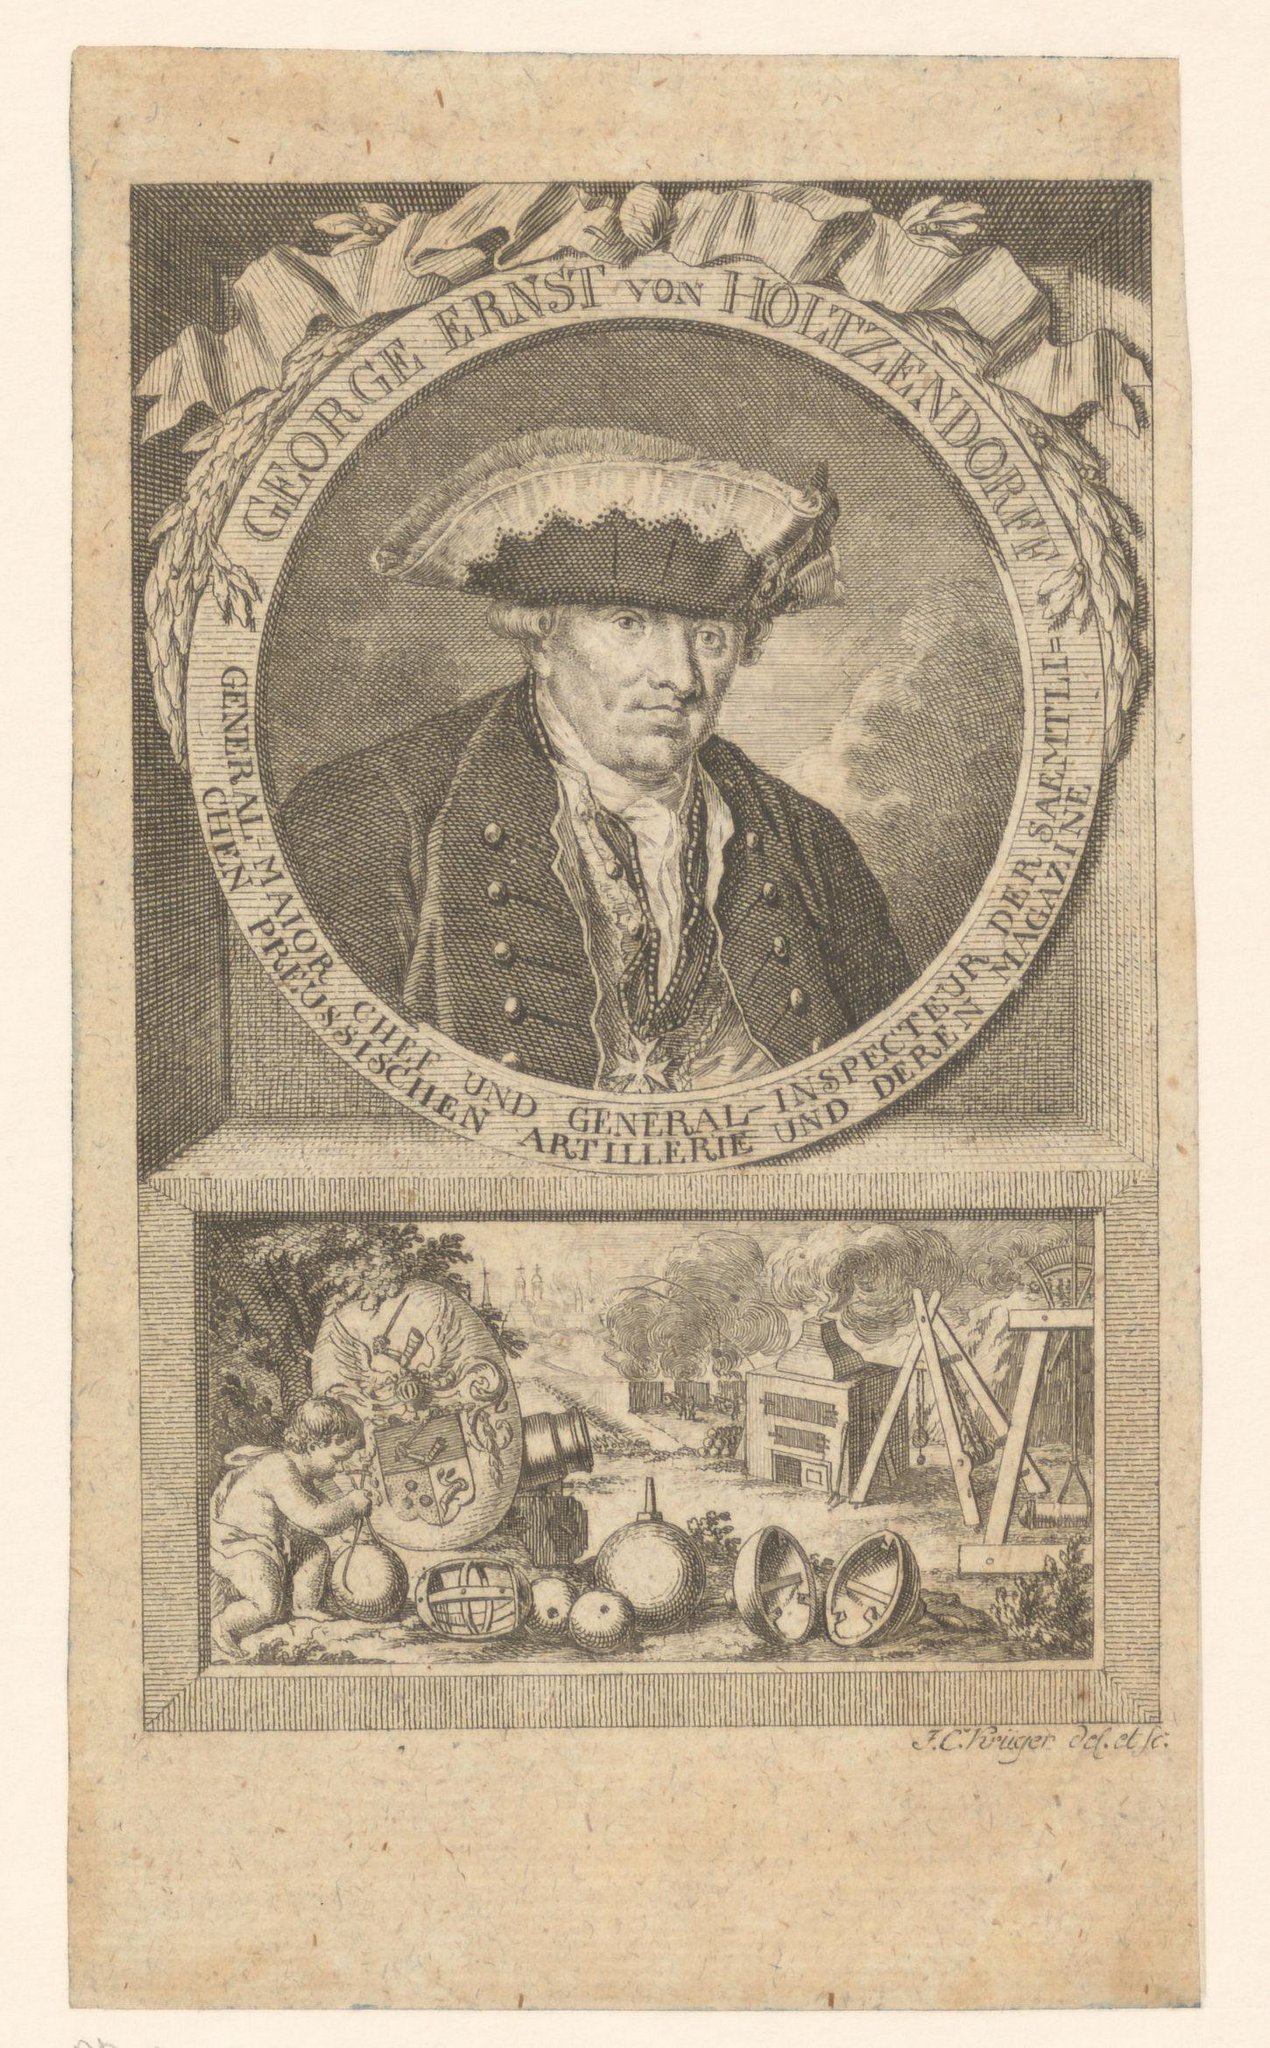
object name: print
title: Portret van Georg Ernst von Holtzendorf en voorstelling een putto bij artillerie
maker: johann conrad krüger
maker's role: artist, painter, print maker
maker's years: 1733-1791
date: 1743-1791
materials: paper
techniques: engraving, etching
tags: berlin, commander-in-chief, general, marshal, historical persons, projectiles, explosives, etc.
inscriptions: collector's mark: Lugt 2228